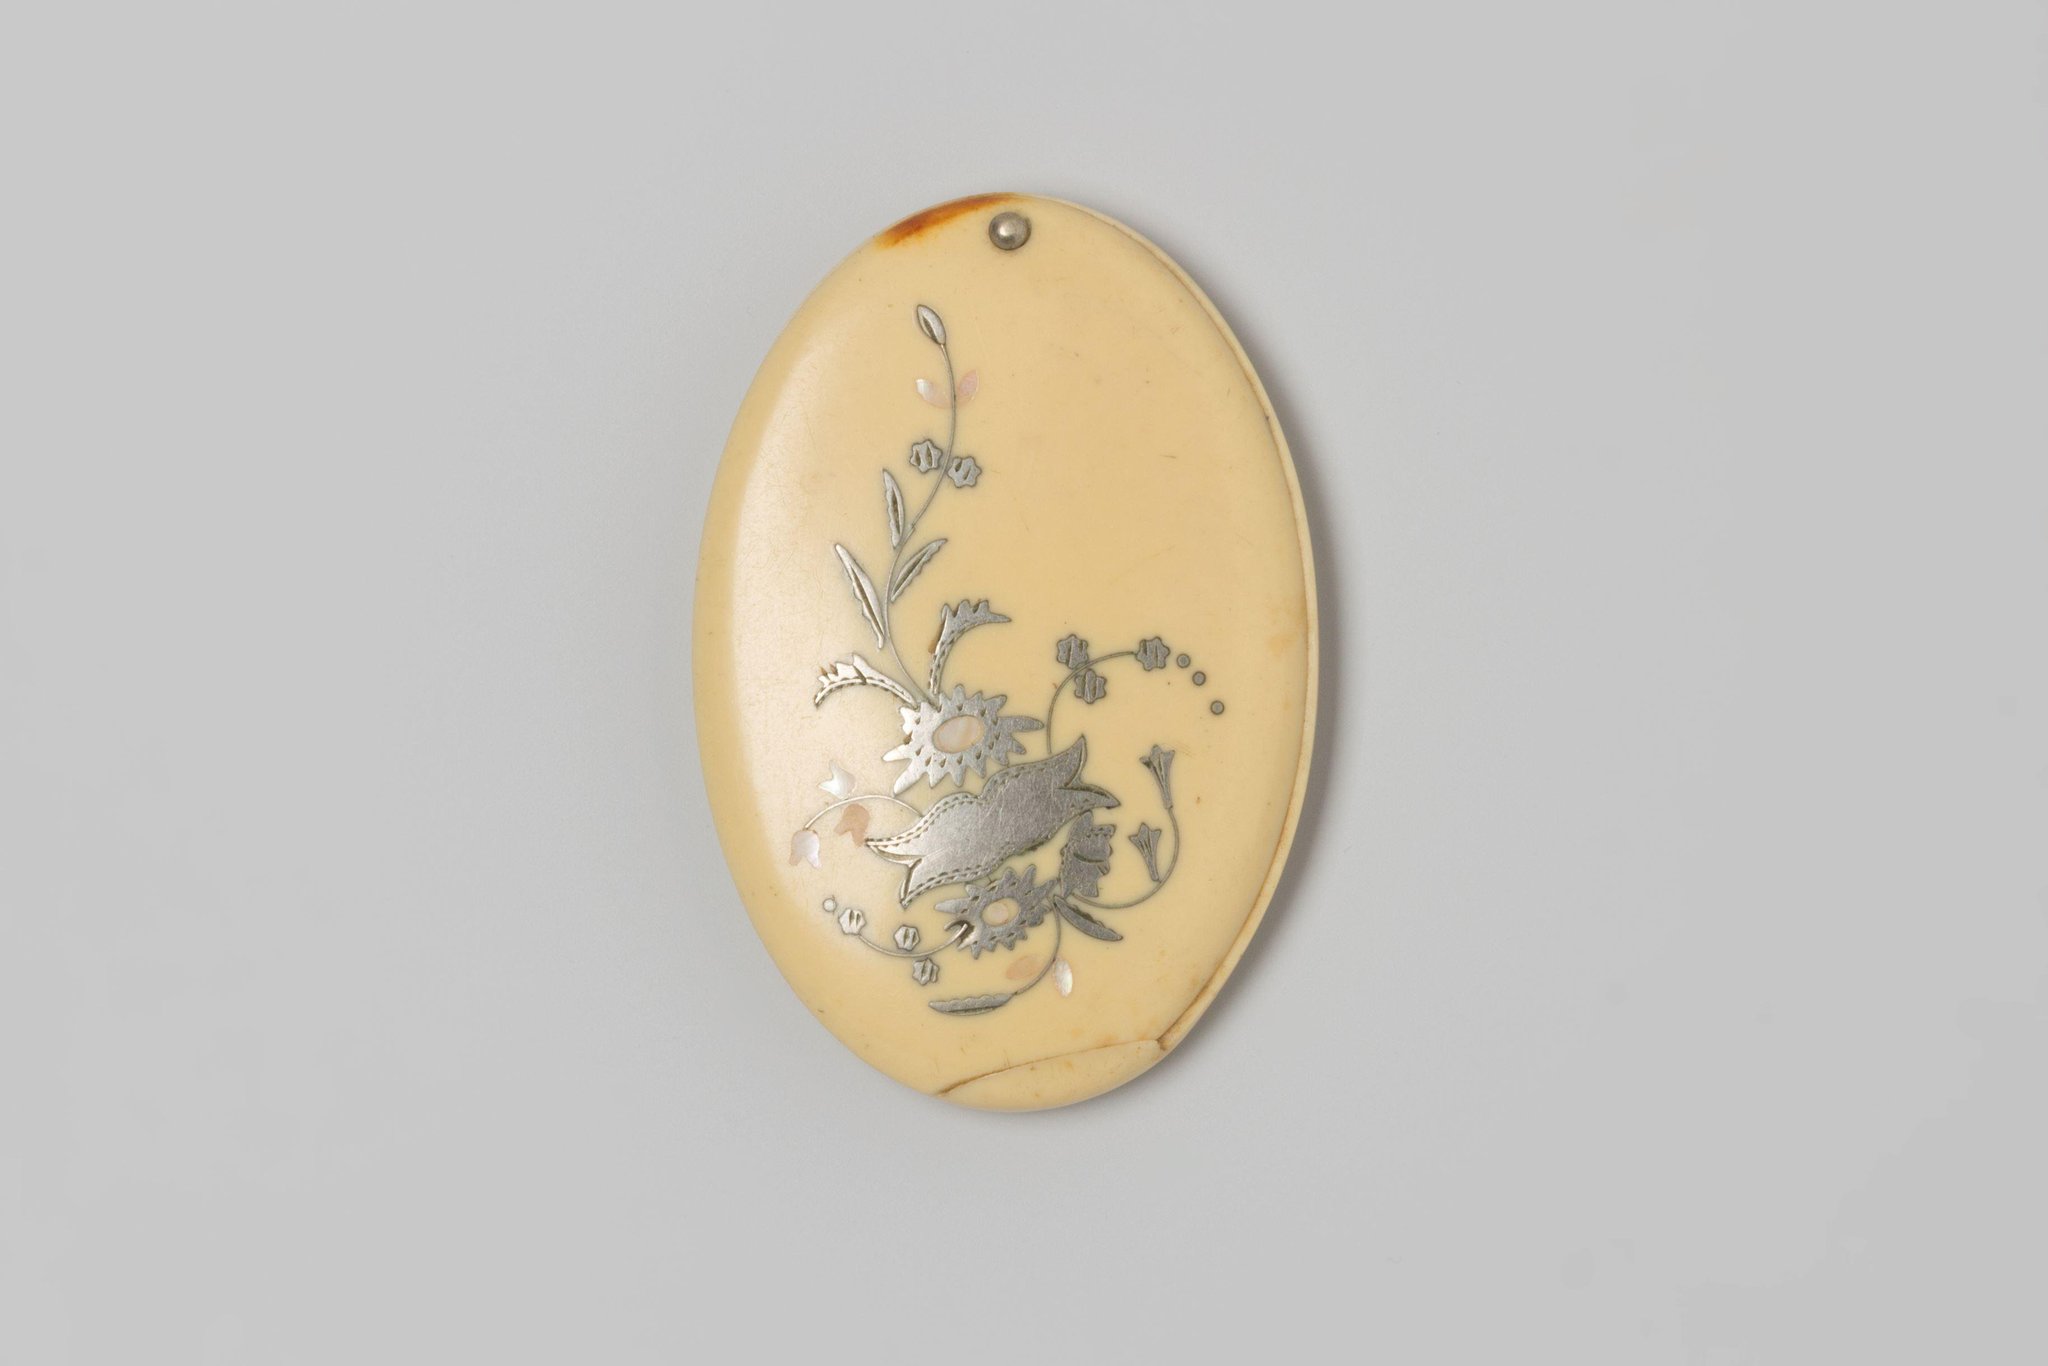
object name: pocket mirror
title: Zakspiegel in een ivoren etui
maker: Anonymous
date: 1860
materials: ivory, mother of pearl, silver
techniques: inlay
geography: western europe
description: Zakspiegeltje in ovaal ivoren etui met inlegwerk van zilver en parelmoer: een cartel en bloemtakje, ca 1860.